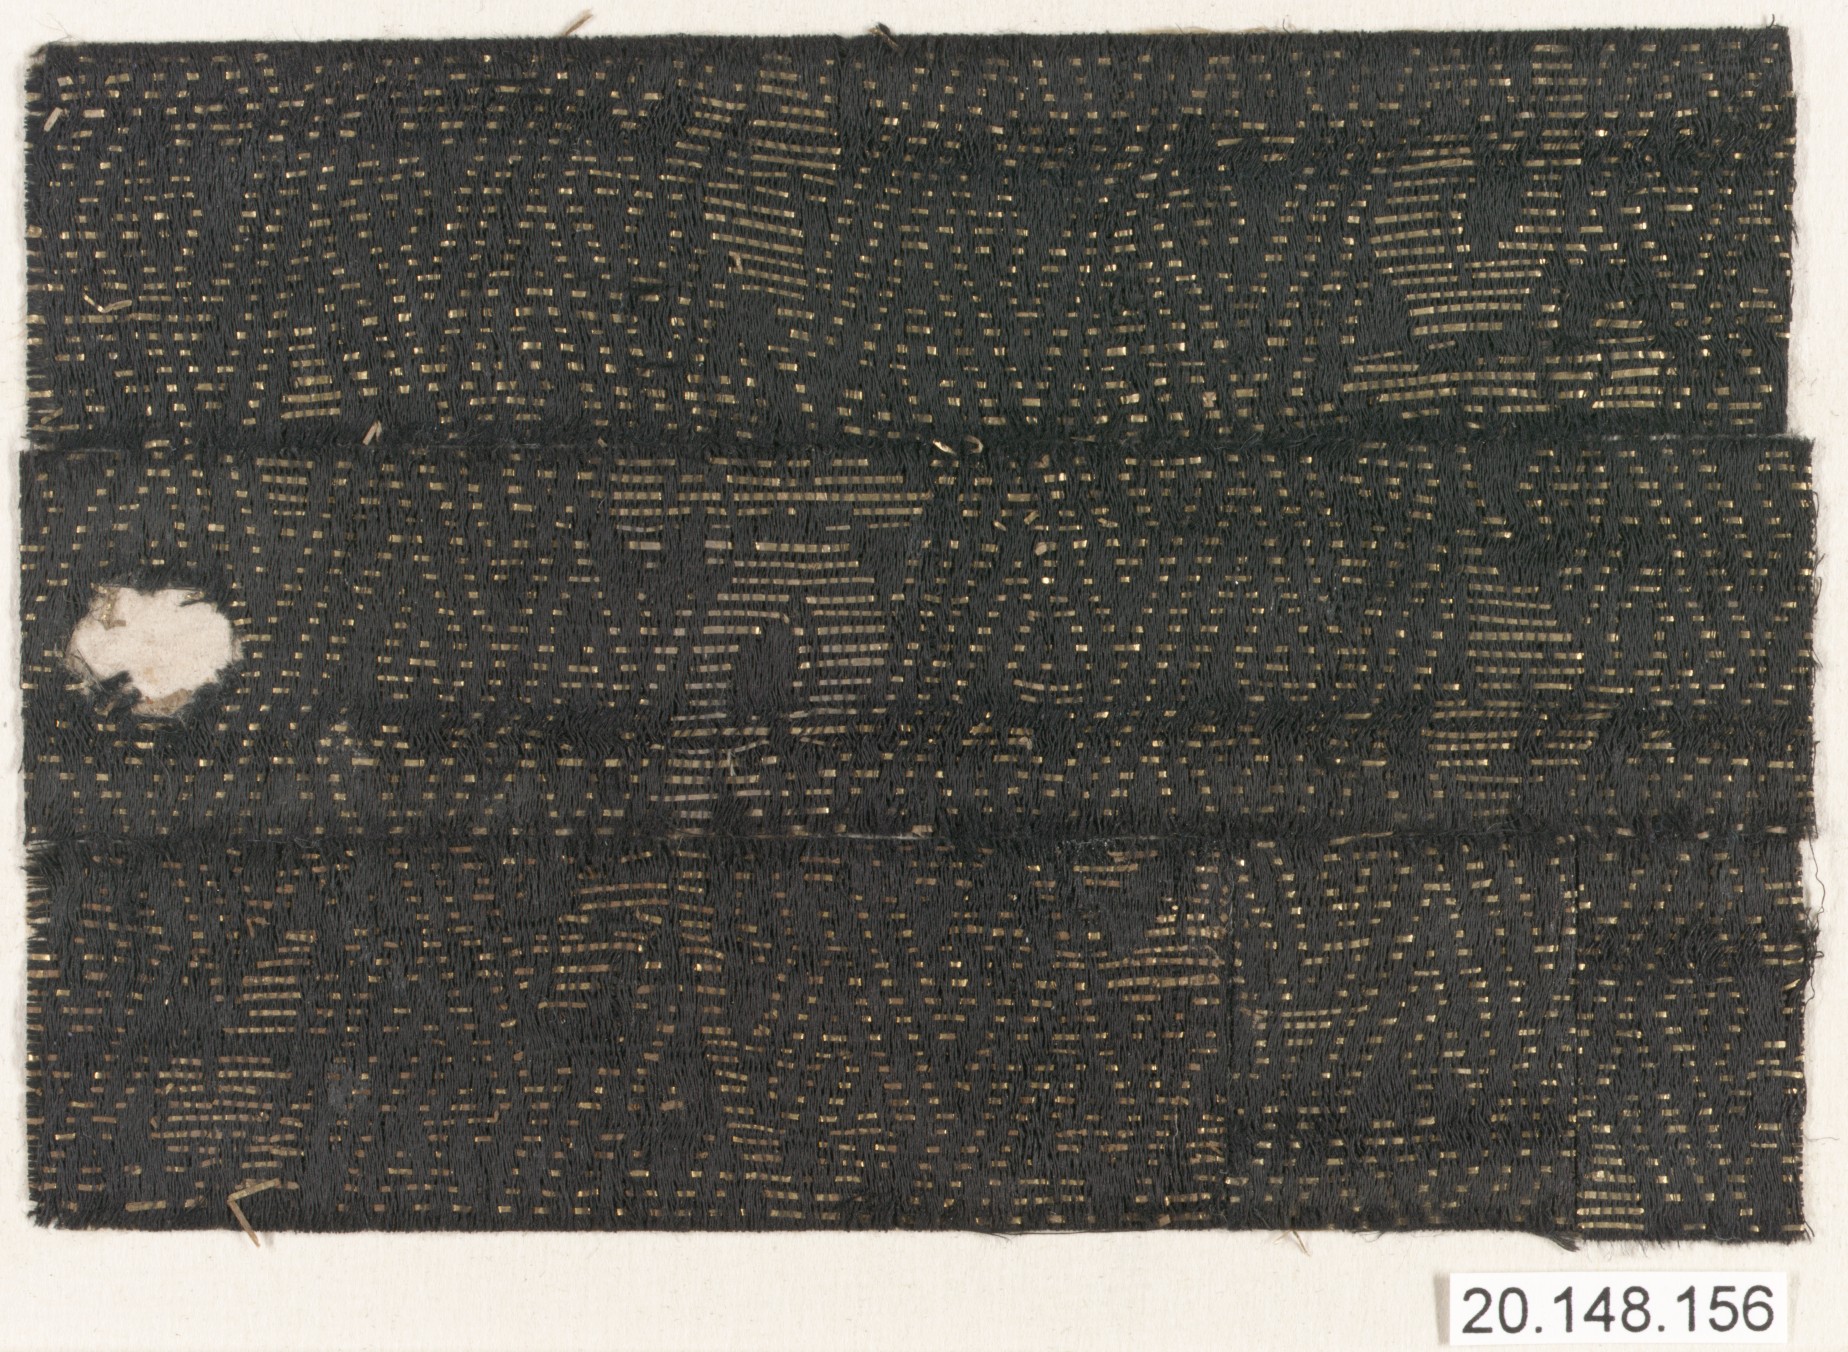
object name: piece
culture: china or japan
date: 1601-1700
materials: silk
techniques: compound weave